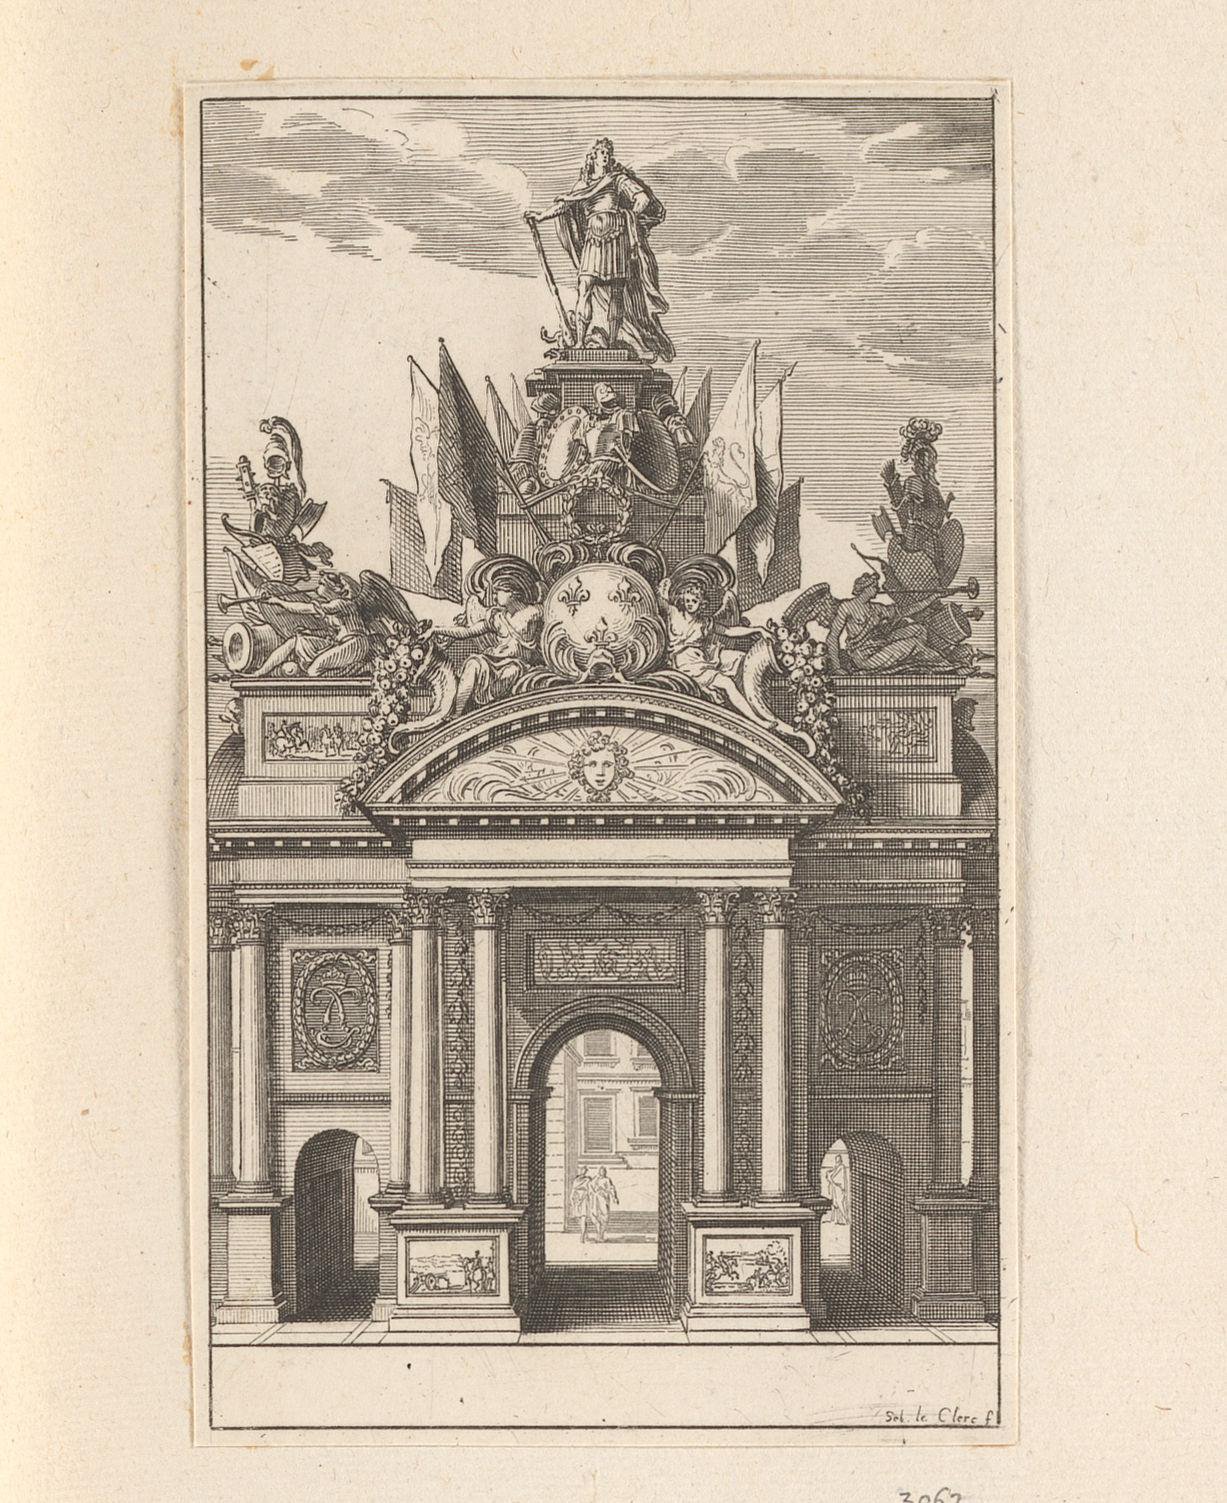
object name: album leaf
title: Gezicht op een triomfboog met de initialen van Lodewijk XIV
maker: sébastien leclerc (i)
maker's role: print maker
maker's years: 1637-1714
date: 1686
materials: paper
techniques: engraving, etching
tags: triumphal arch, title-page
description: Titelpagina voor: Scudéry, Madeleine de. Conversations morales. De l'esperance, l'envie (...). Parijs: s.n., 1686.